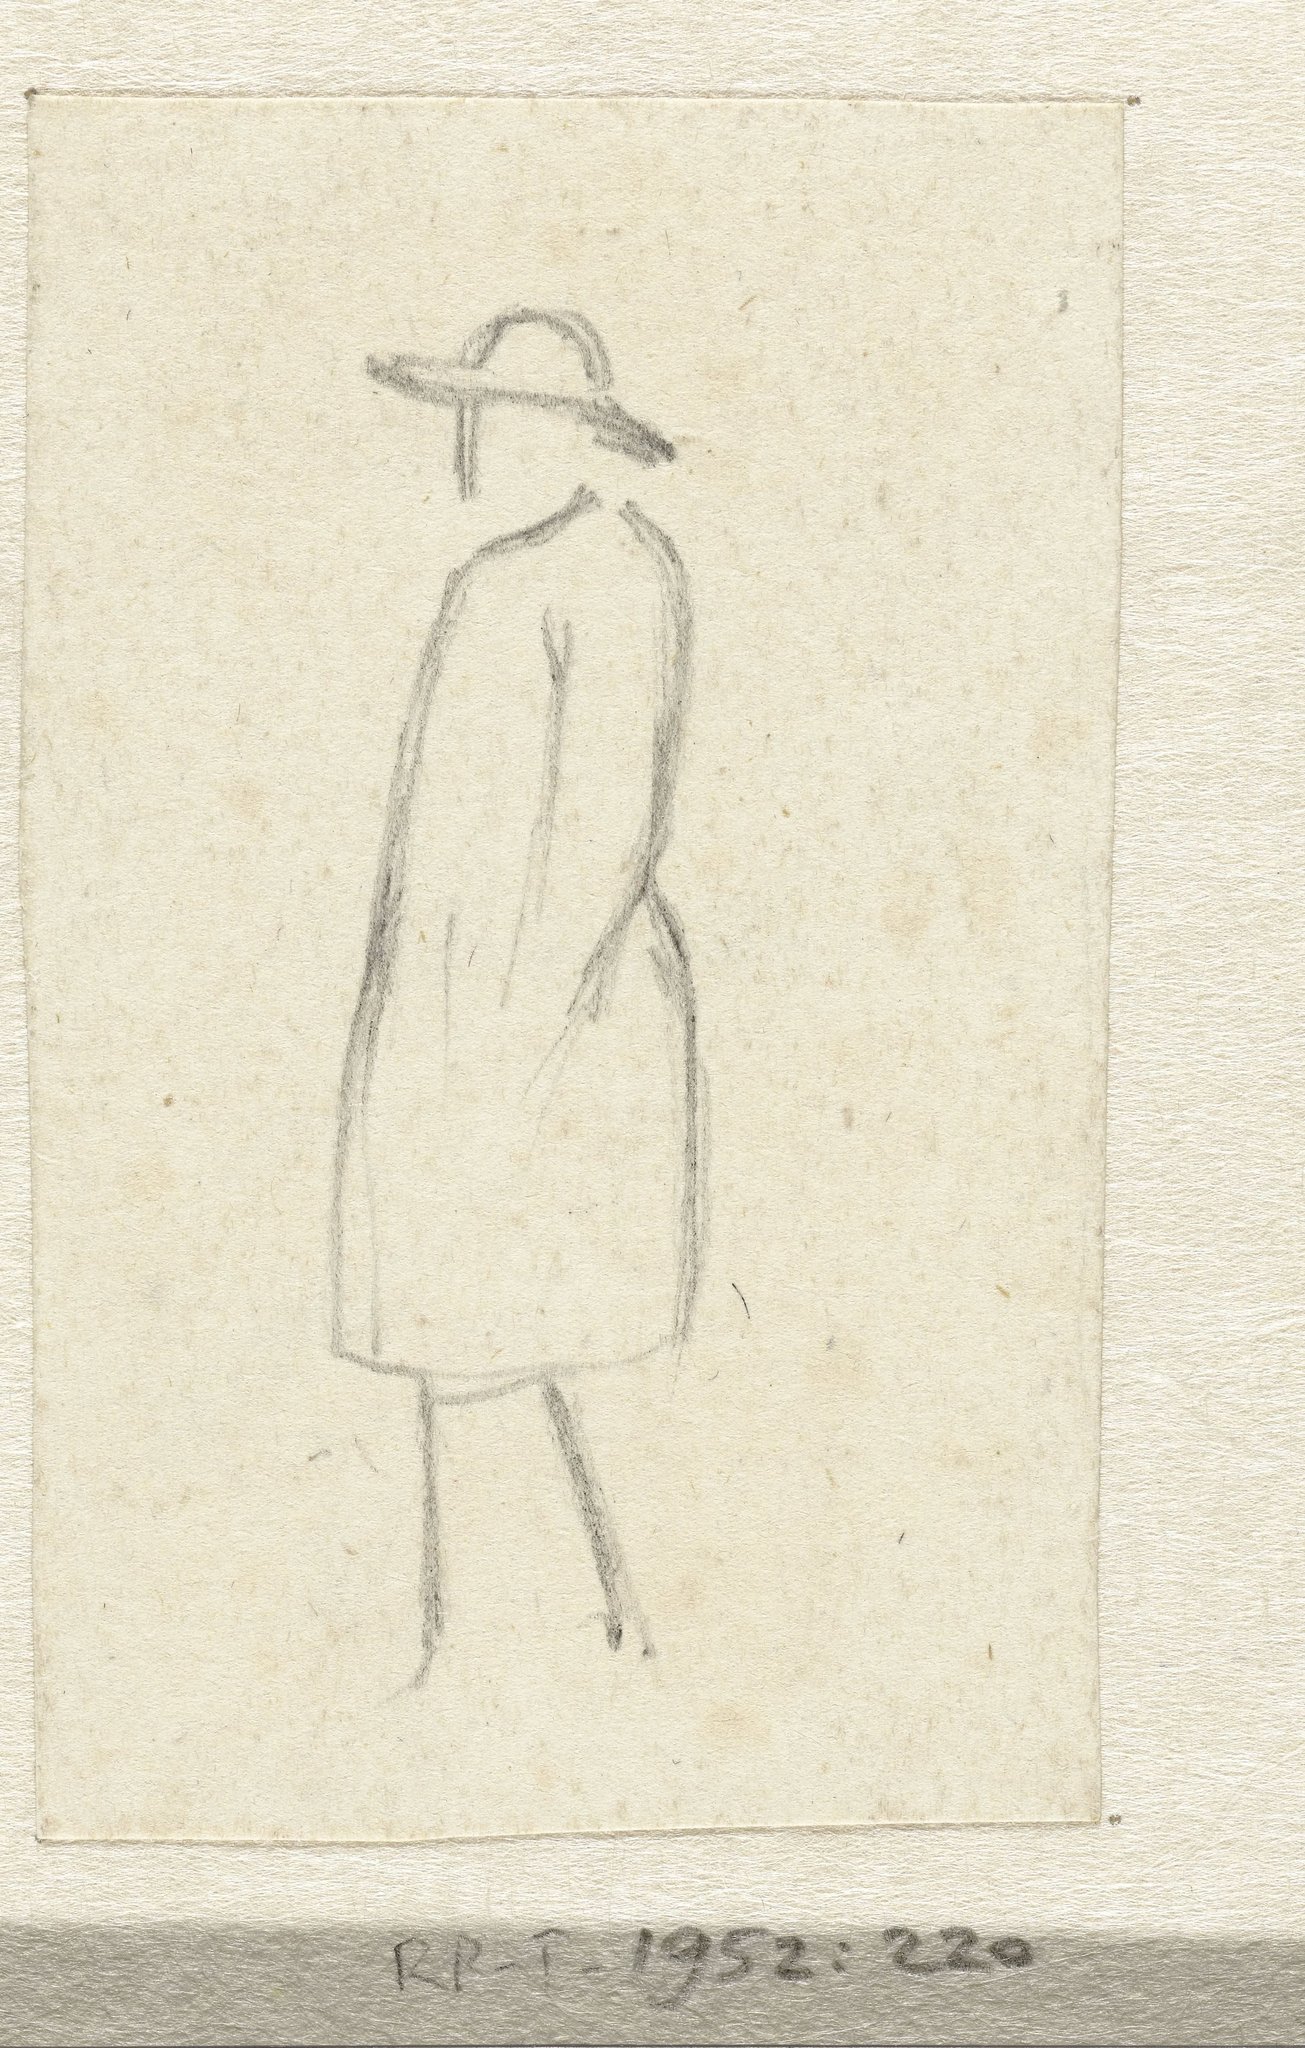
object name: drawing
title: Staande man met hoed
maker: simon andreas krausz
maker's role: draughtsman, print maker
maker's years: 1760-1825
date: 1770-1825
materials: paper, pencil